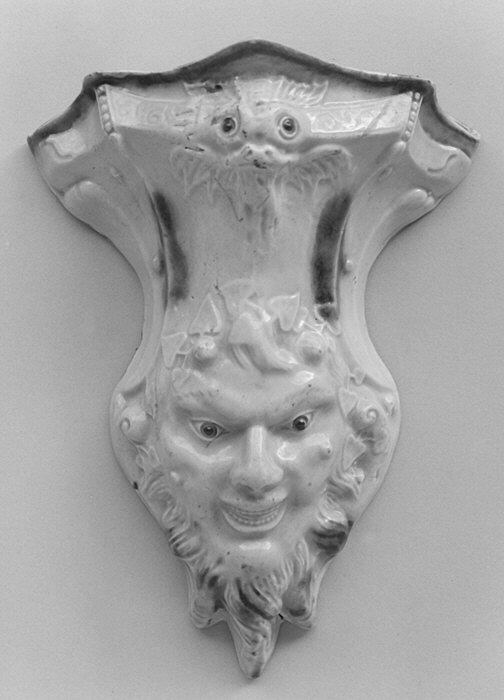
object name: wall pocket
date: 1745-1750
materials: stoneware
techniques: salt glaze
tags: masks,satyrs